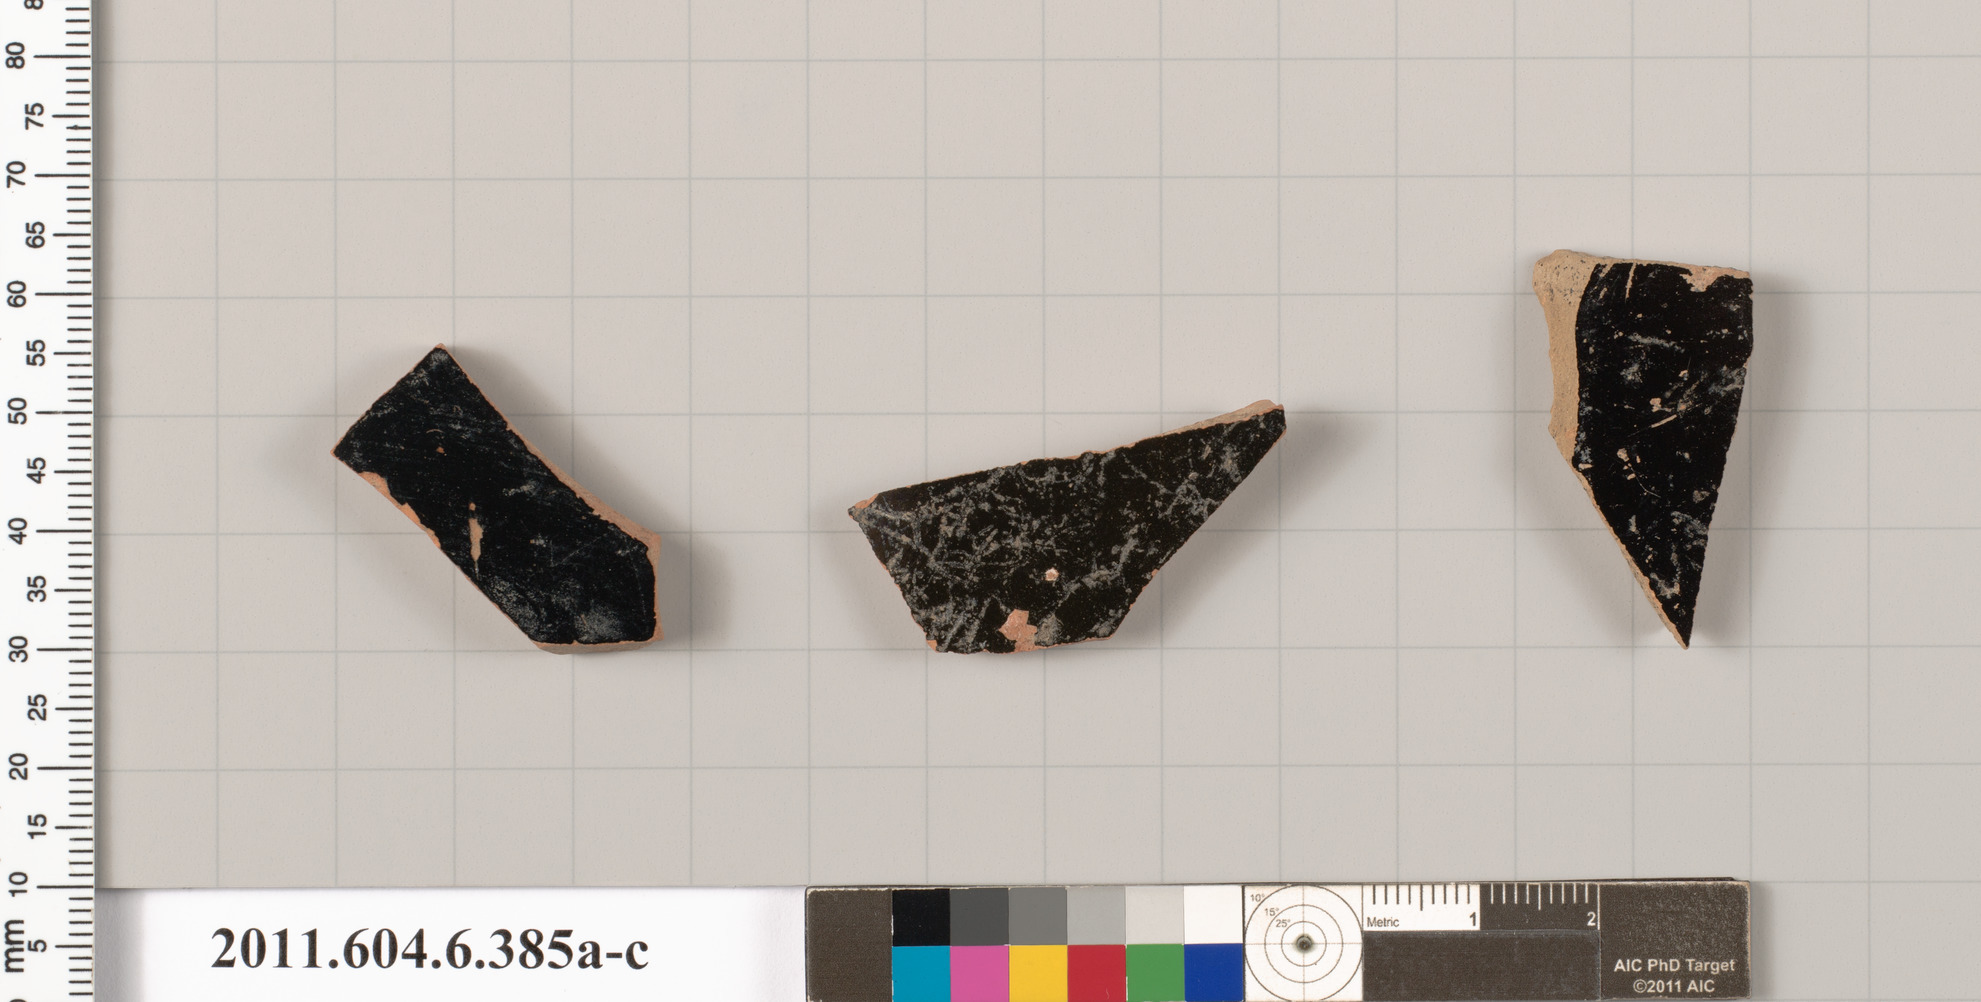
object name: undetermined closed shape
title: Terracotta fragments of closed shapes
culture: greek, attic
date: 600-401 BCE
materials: terracotta